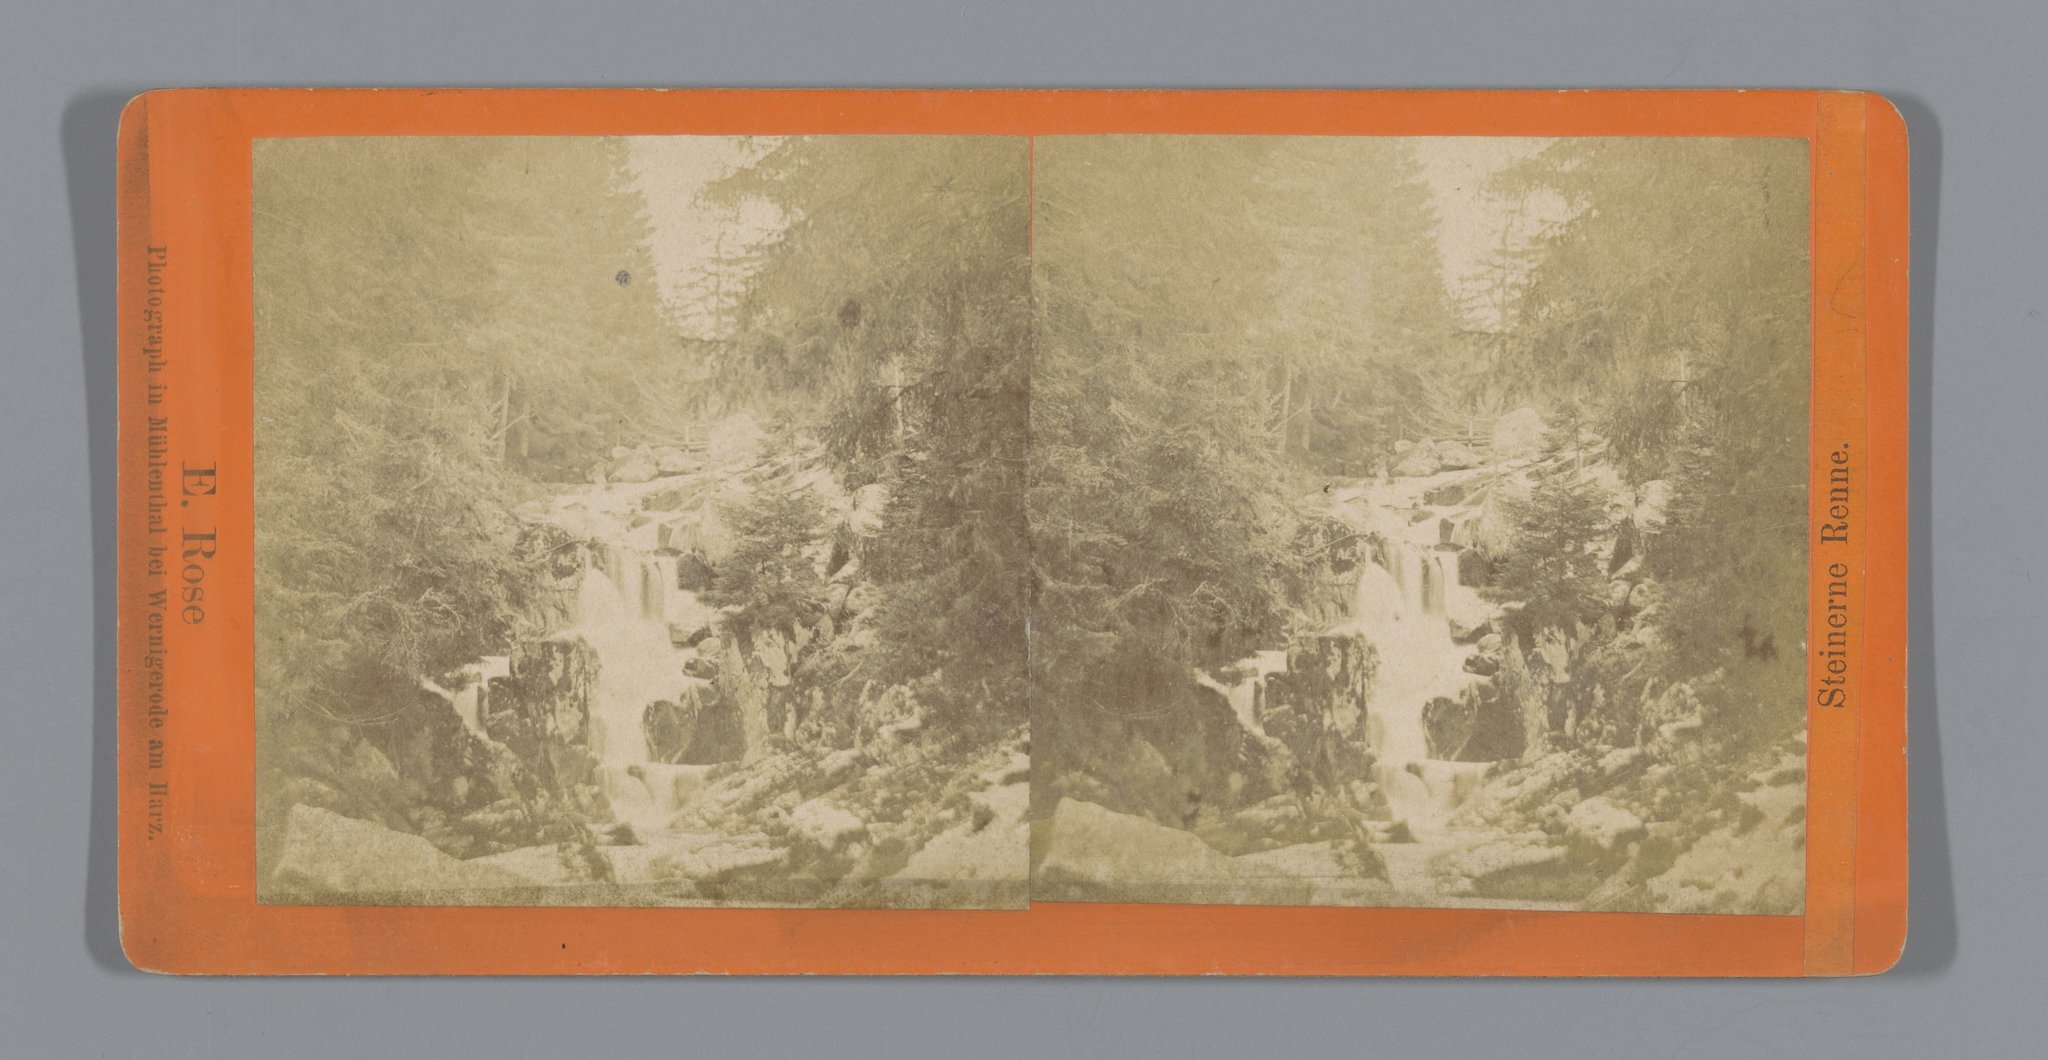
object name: stereograph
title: Steinerne Renne nabij Wernigerode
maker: e. rose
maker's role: fotograaf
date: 1855-1880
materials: cardboard, photographic support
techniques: albumen print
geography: harz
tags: brook